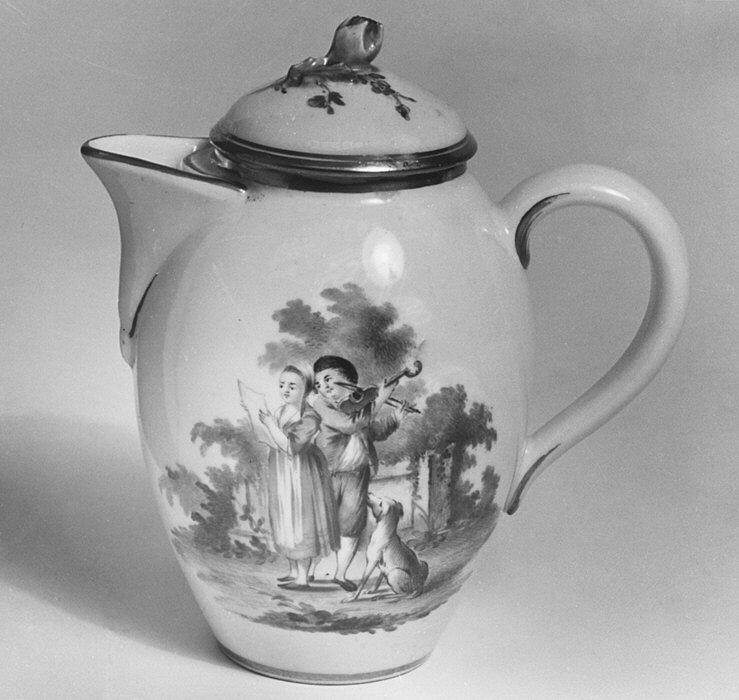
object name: milk jug with cover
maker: gotha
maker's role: factory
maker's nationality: german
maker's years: 1757-1900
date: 1780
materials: hard paste porcelain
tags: men,women,dogs